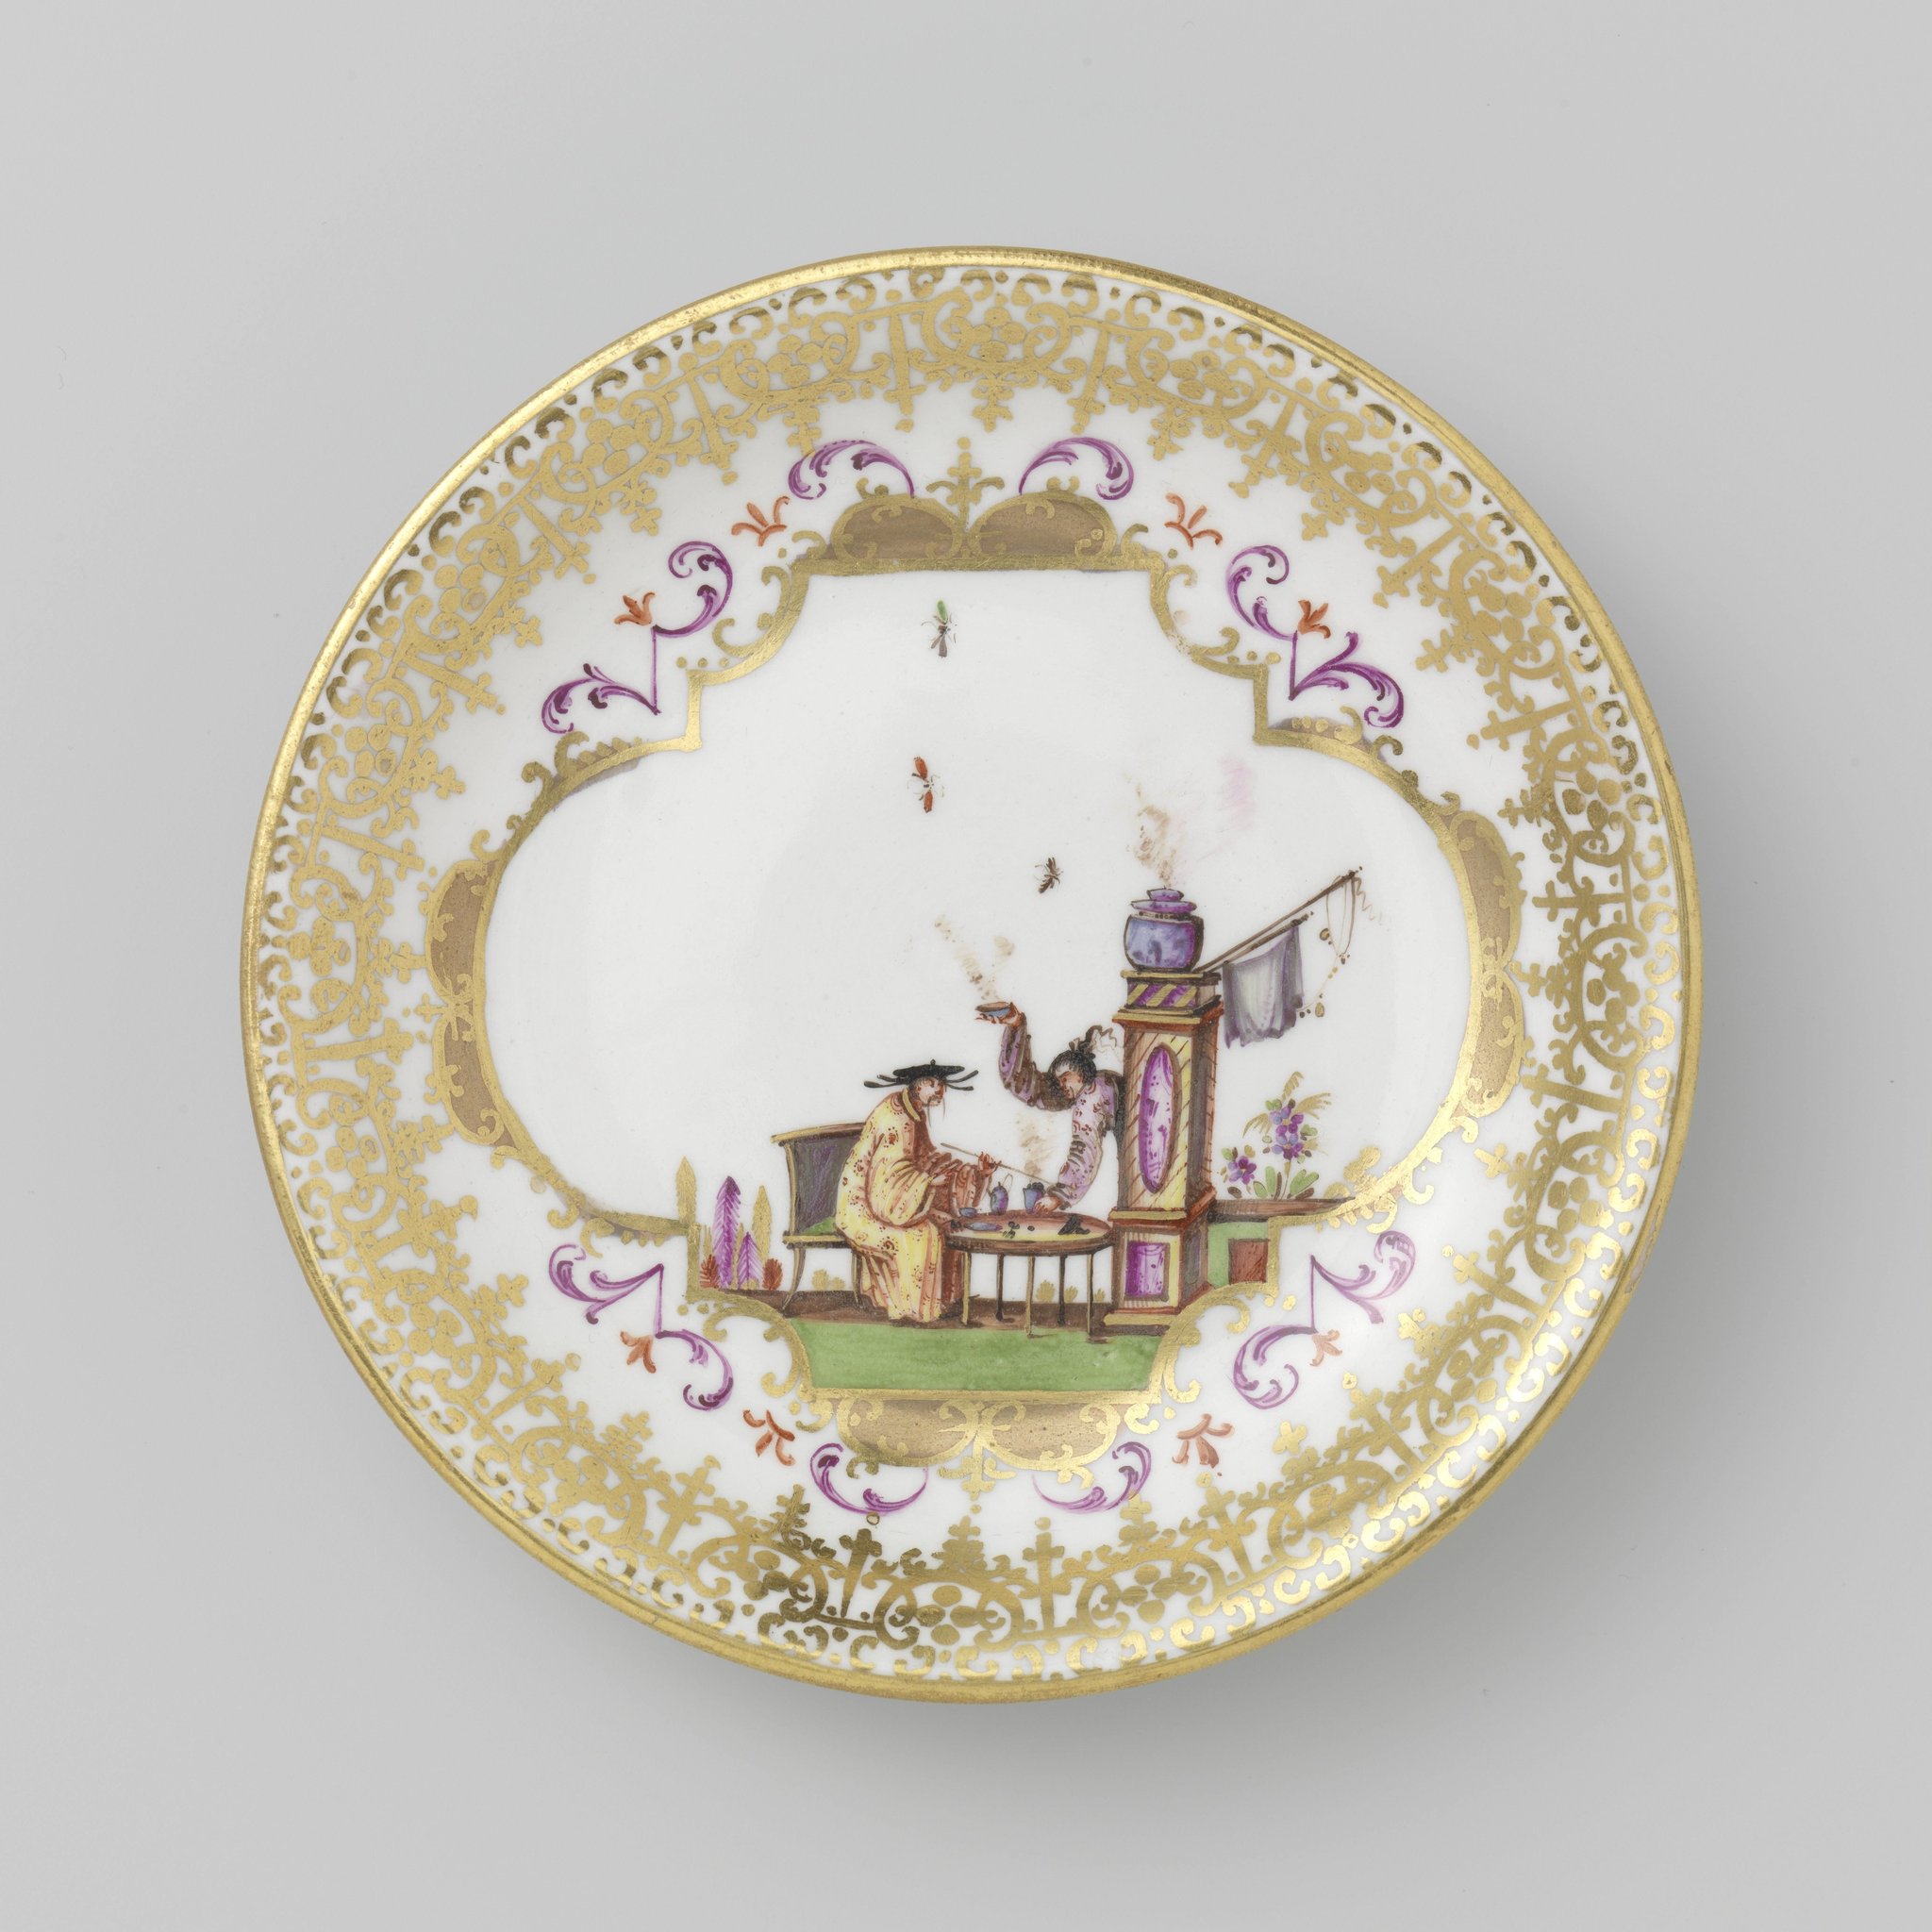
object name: eating drinking utensil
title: Schotel, veelkleurig beschilderd met chinoiserieën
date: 1725-1730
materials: porcelain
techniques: painted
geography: meissen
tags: catharina de grote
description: Tea service on silver-gilt stand. Porcelain and silver gilt. Meissen, c. 1725 - 1730, the stand Augsburg, c. 1730, by Johannes Engelbrecht. From the possessions of Catharine the Great of Russia